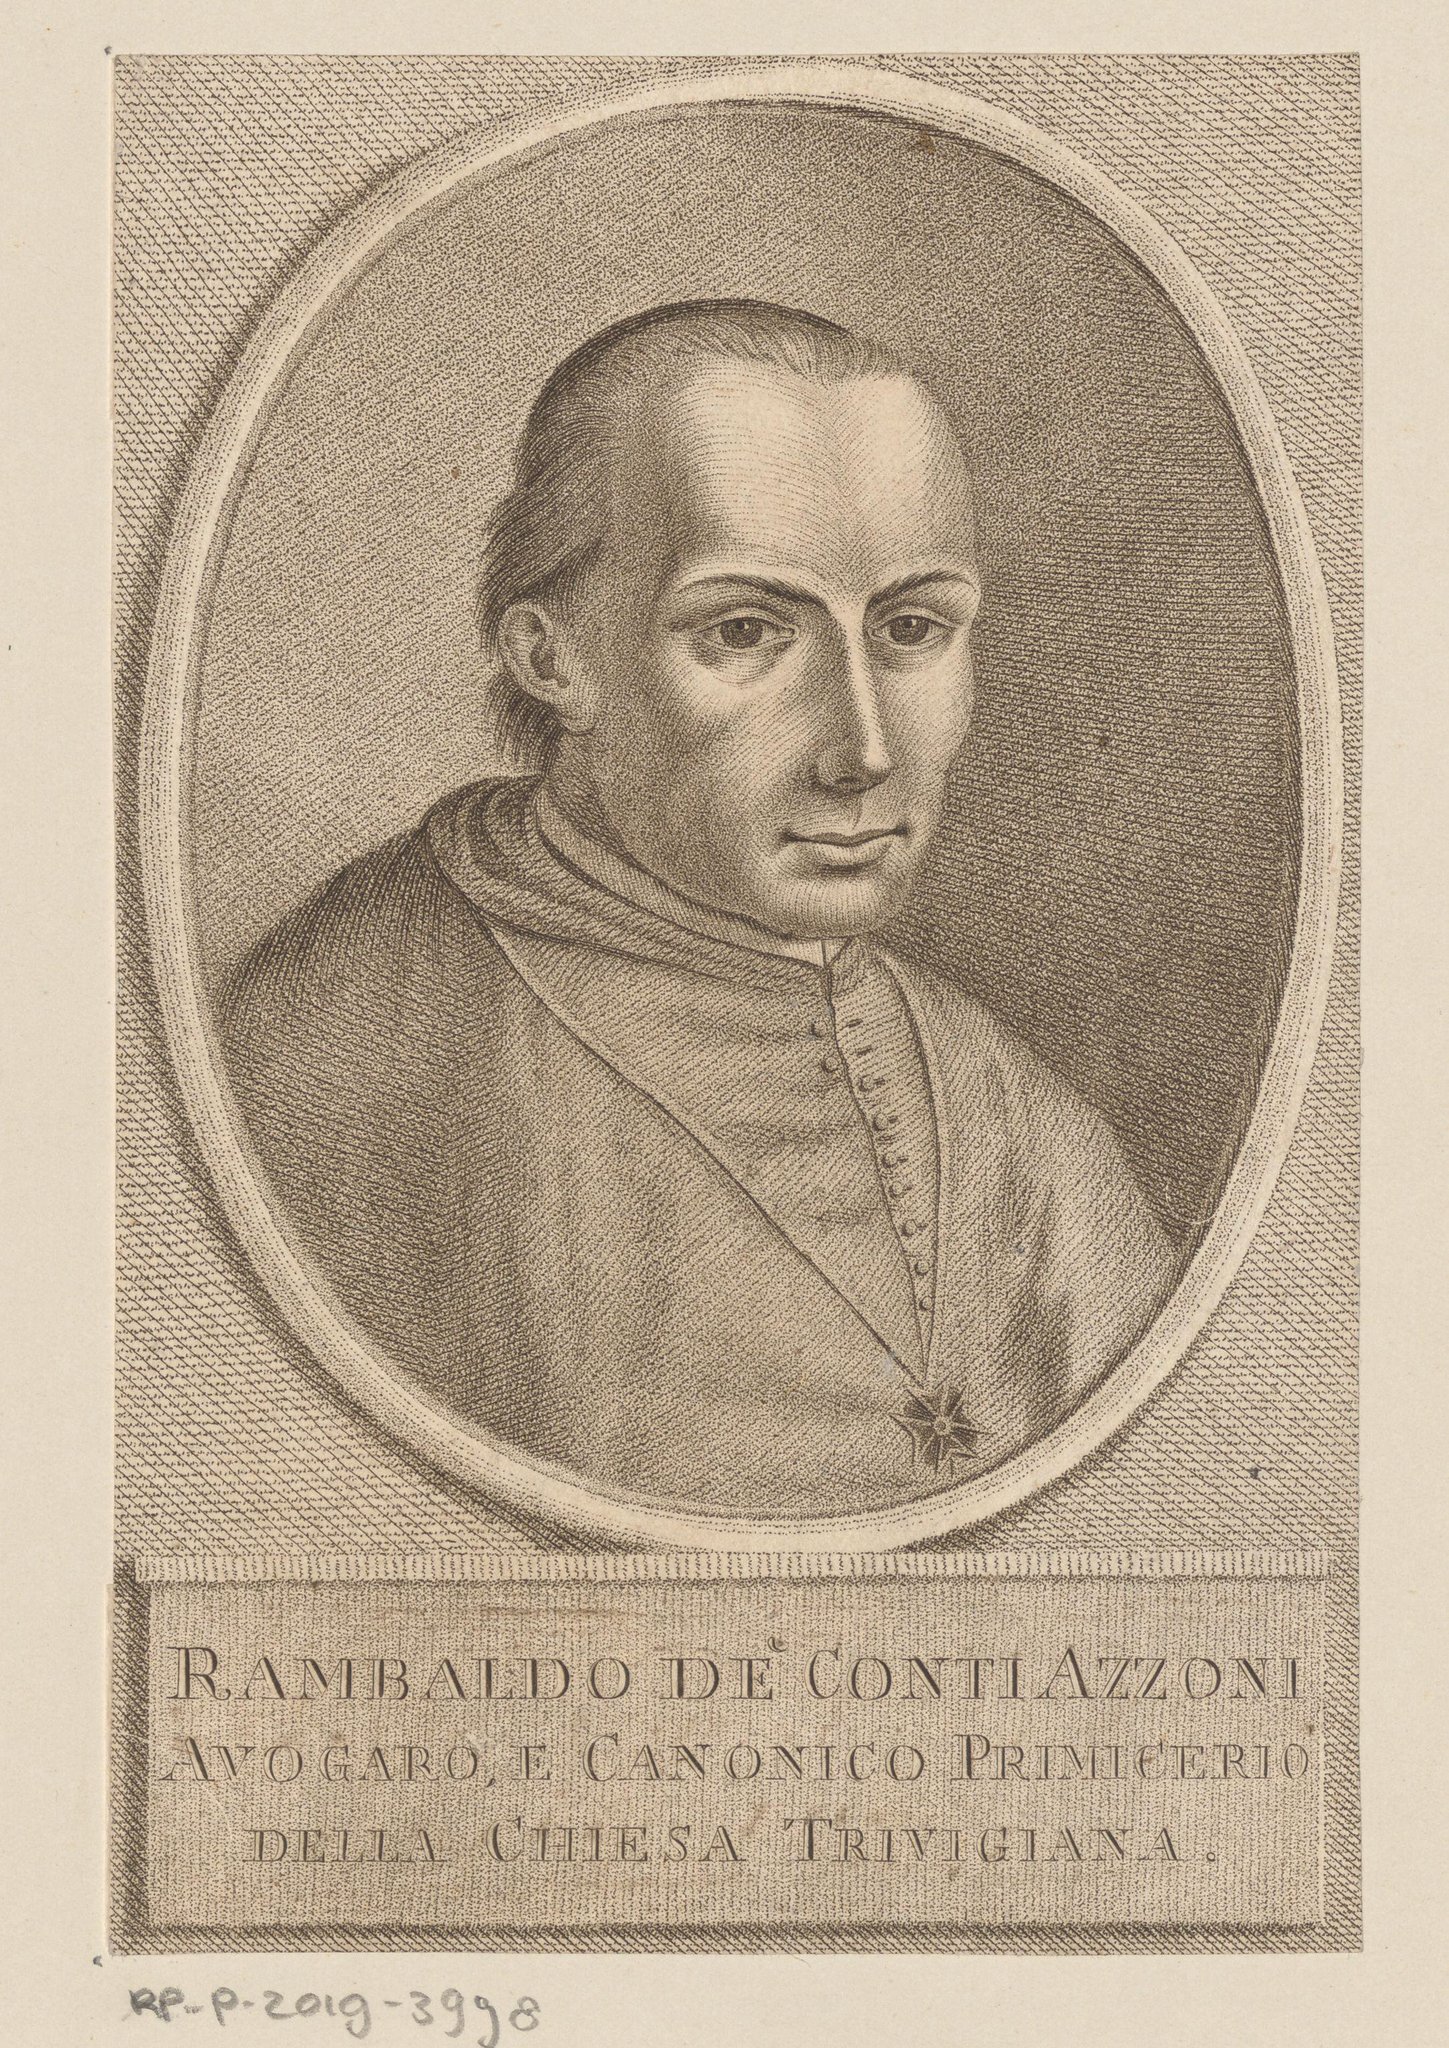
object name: book illustration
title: Portret van Rambaldo van Azzoni Avogaro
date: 1791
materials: paper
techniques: etching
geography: bassano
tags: historical persons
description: Prent uit: Tiraboschi, Girolamo. Elogio storico di Rambaldo de' conti Azzoni Avogaro (...). Bassano: s.n., 1791.